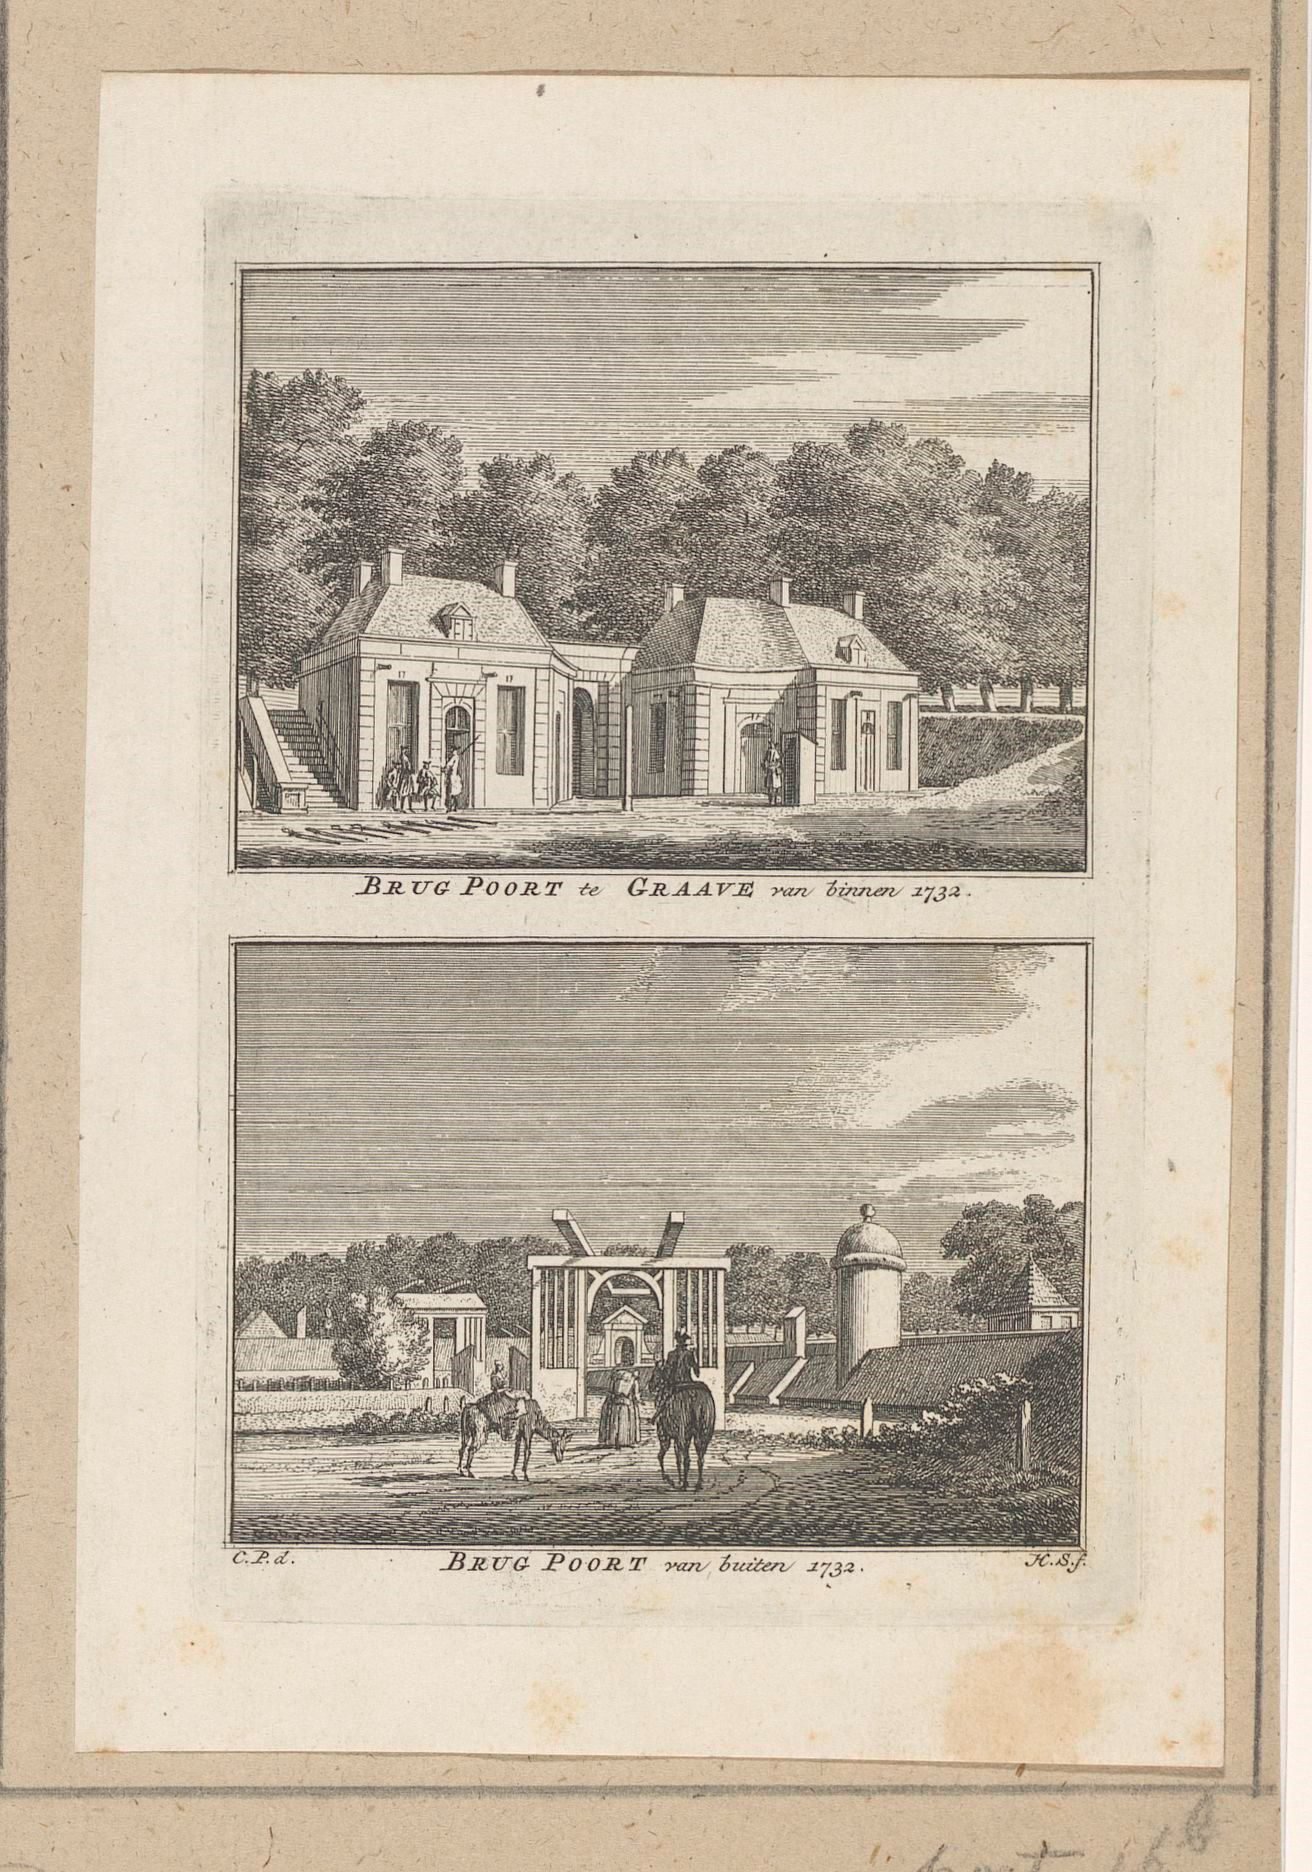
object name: book illustration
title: Gezicht op de Brugpoort van binnen Grave en gezicht op de Brugpoort van buiten Grave, 1732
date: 1746-1792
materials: paper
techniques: engraving, etching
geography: haarlem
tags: city-gate, grave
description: Prent ook gebruikt in: Het verheerlykt Nederland of kabinet van hedendaagsche gezigten van steden, dorpen (…). 9 delen. Amsterdam: Isaak Tirion en weduwe Isaak Tirion, 1745-1774, dl. 1 (1745), ill. 13-14. Of in: Nederlandsche tafereelen; of eene keurige verzameling van negen honderd fraaije gezigten van steden, dorpen, sloten, oudheden (…). 9 delen. Amsterdam: Jan de Groot, 1792, dl. 1, ill. 13-14.